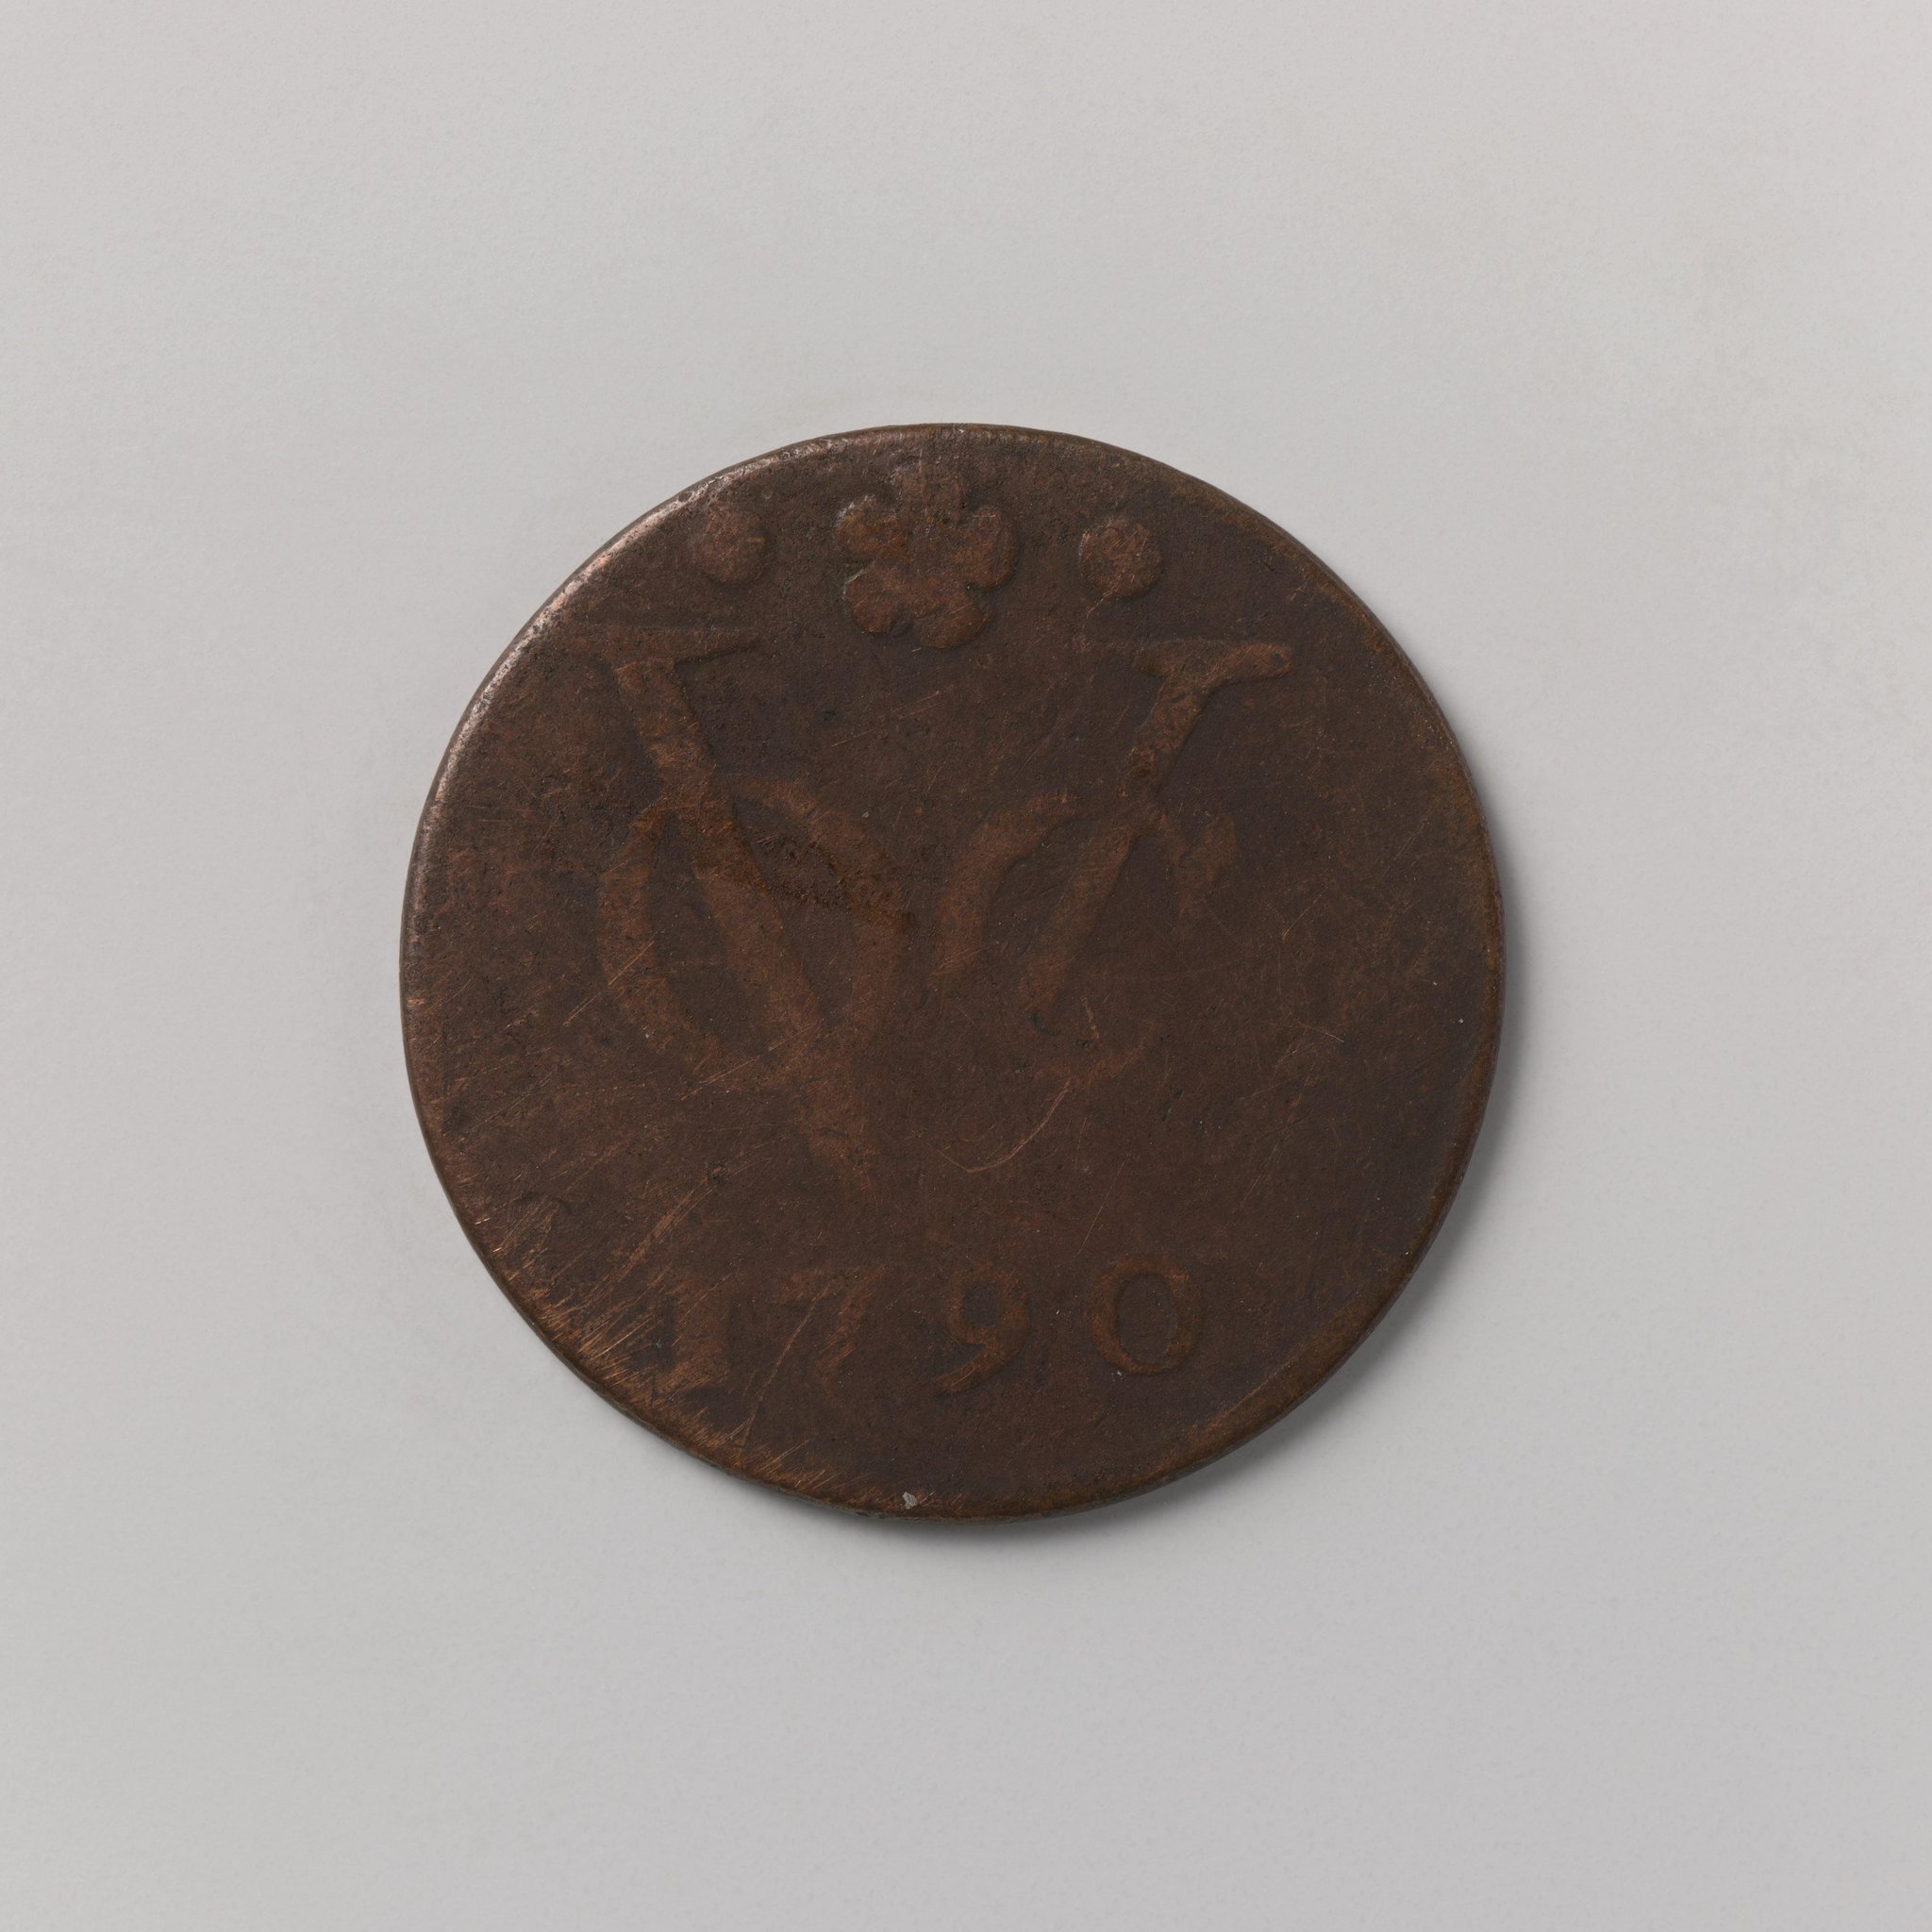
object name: coin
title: VOC, duit Holland, 1790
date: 1790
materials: copper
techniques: striking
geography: dordrecht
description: Koperen munt. Voorzijde: gekroond wapenschild van Holland. Keerzijde: monogram van de VOC, waarboven muntteken en waaronder jaartal. Gladde rand.